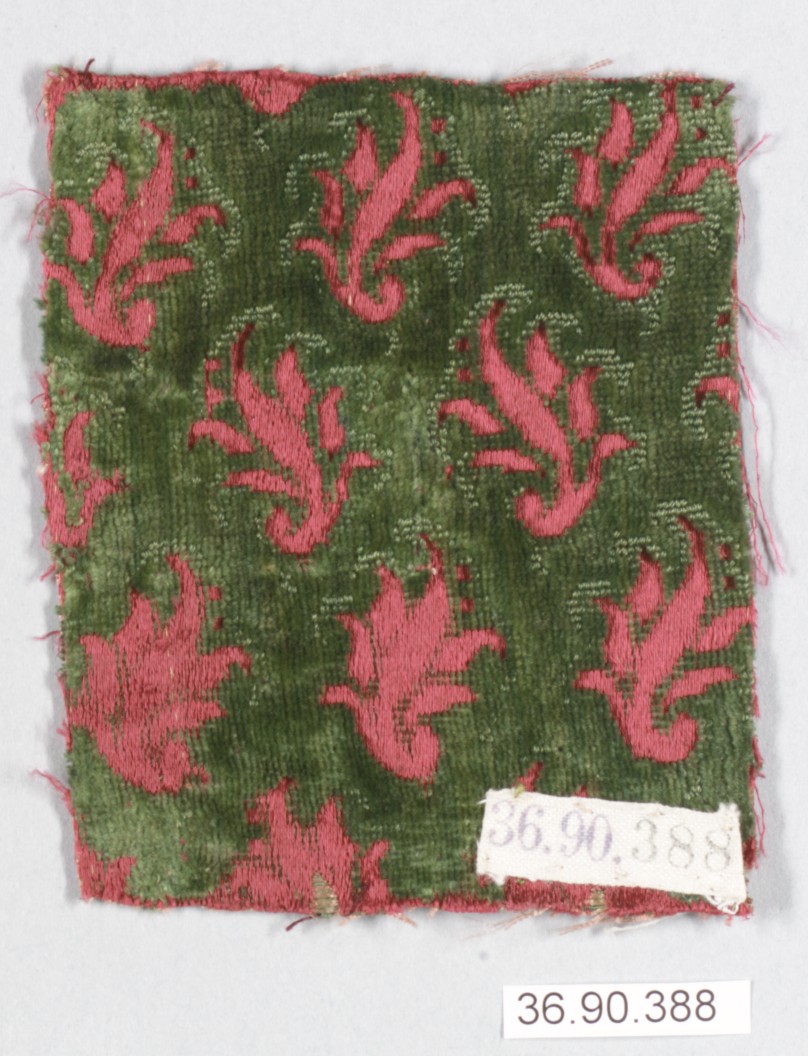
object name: piece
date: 1501-1700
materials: silk